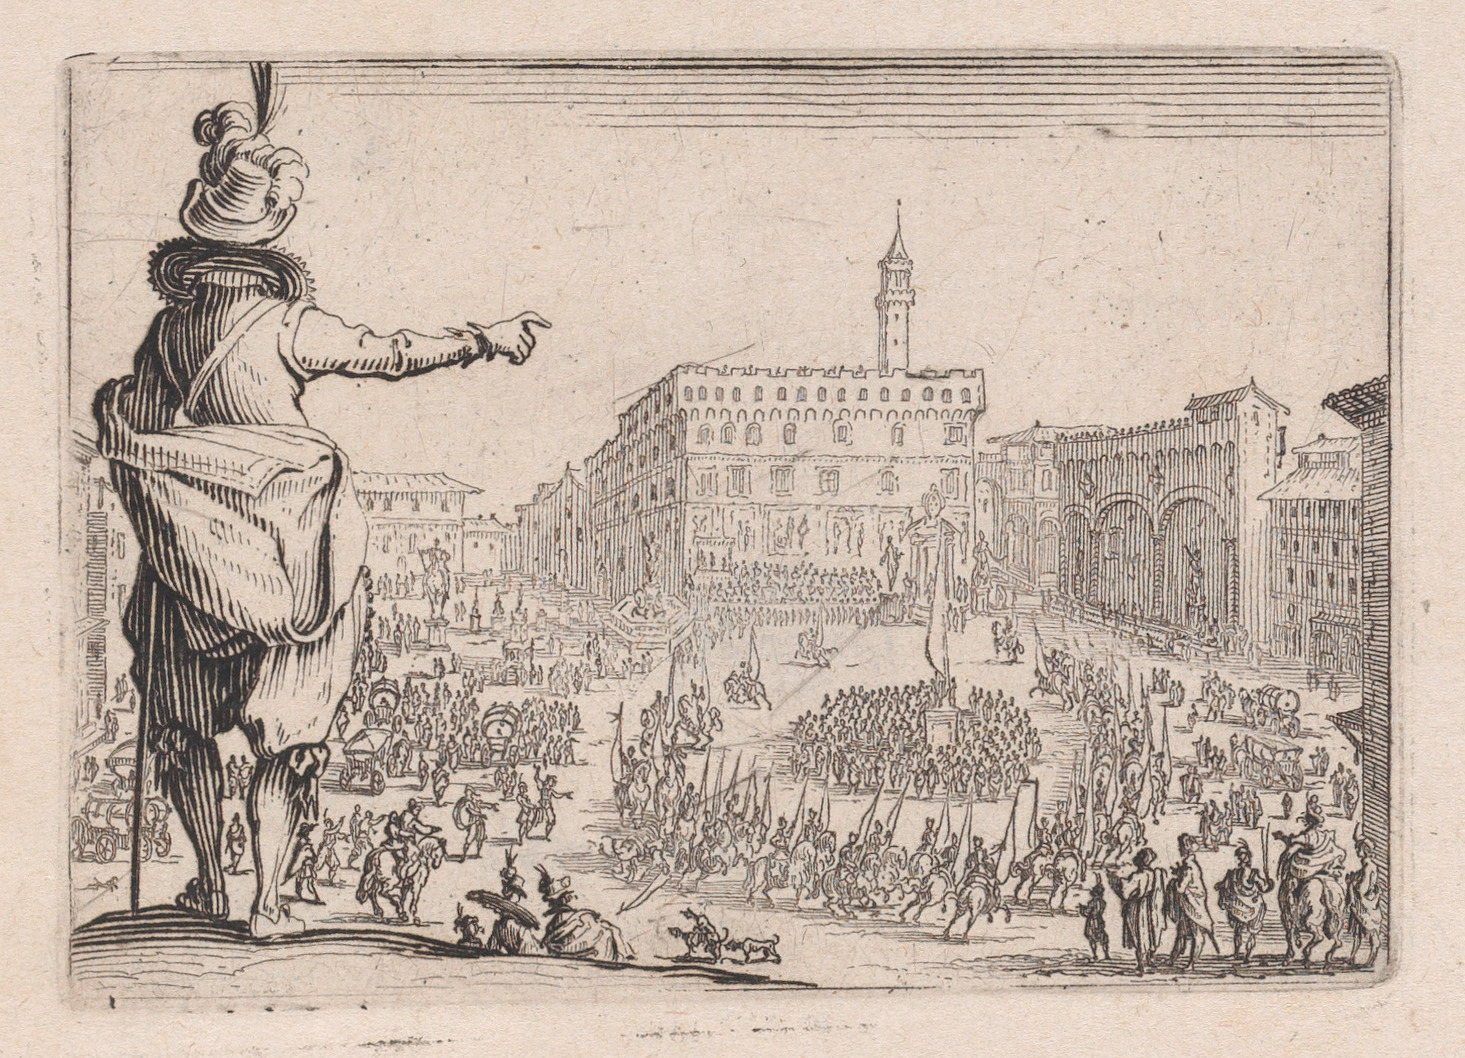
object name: print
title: Une Fête sur la Place de la Signoria a Florence (A Festival in the Piazza della Signoria in Florence), from "Les Caprices" Series B, The Nancy Set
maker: jacques callot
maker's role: artist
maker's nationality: french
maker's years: 1592-1635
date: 1617-1620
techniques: etching